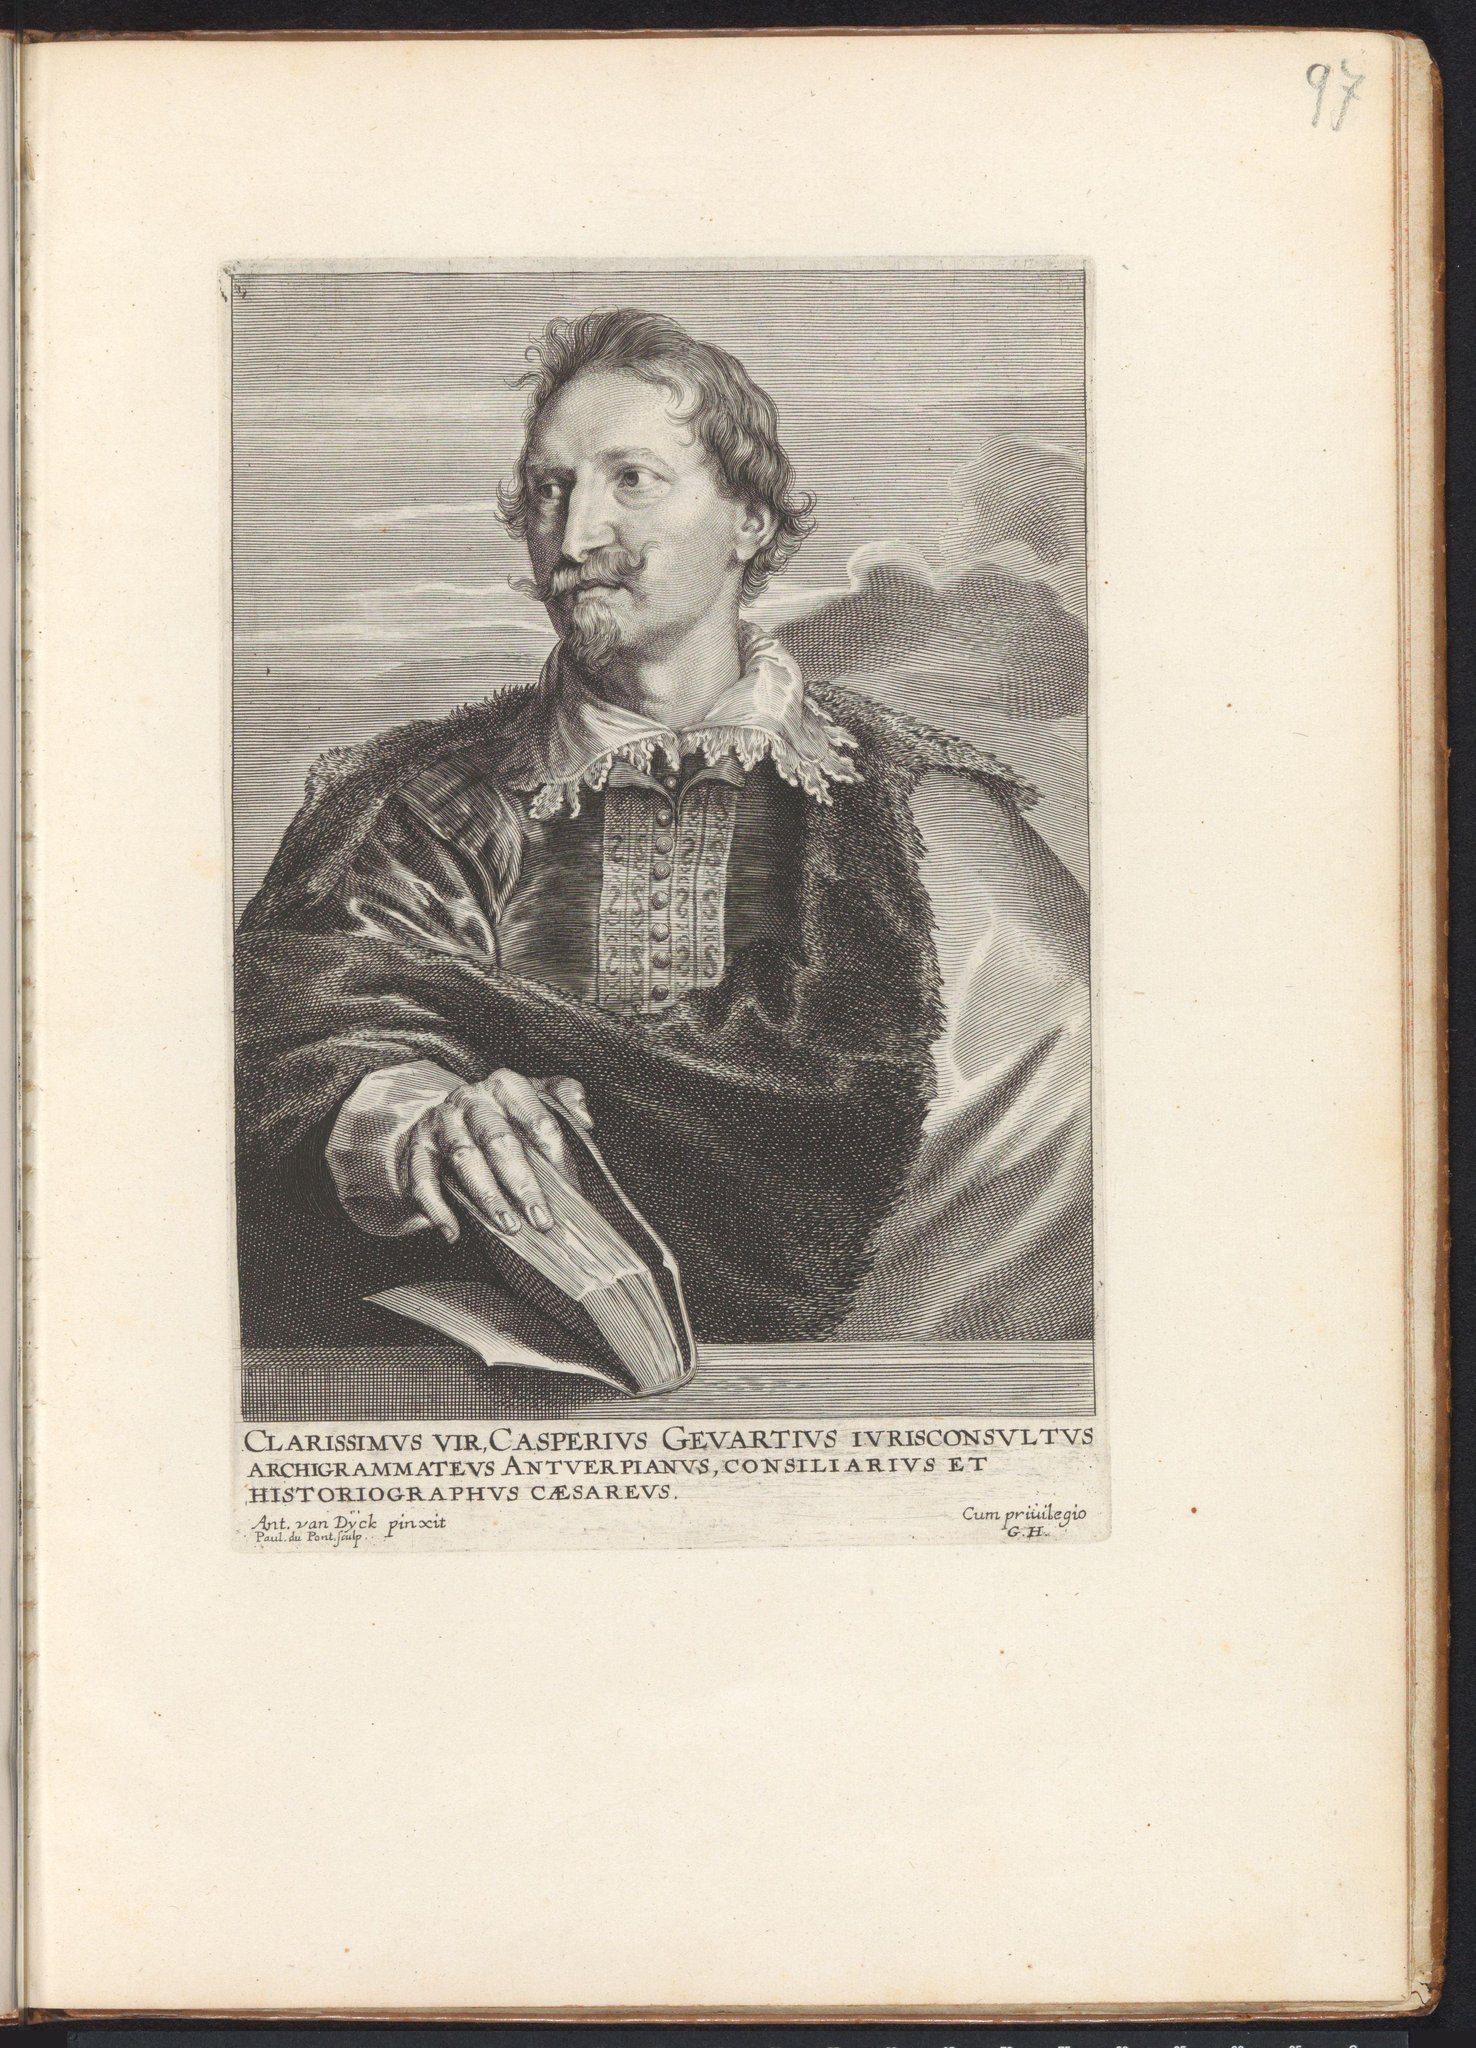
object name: album leaf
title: Portret van de jurist Casper Gevartius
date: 1630-1641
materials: paper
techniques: engraving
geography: antwerp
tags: antwerp, politician, jean gaspard gevartius, book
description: Deze prent maakt deel uit van een album.